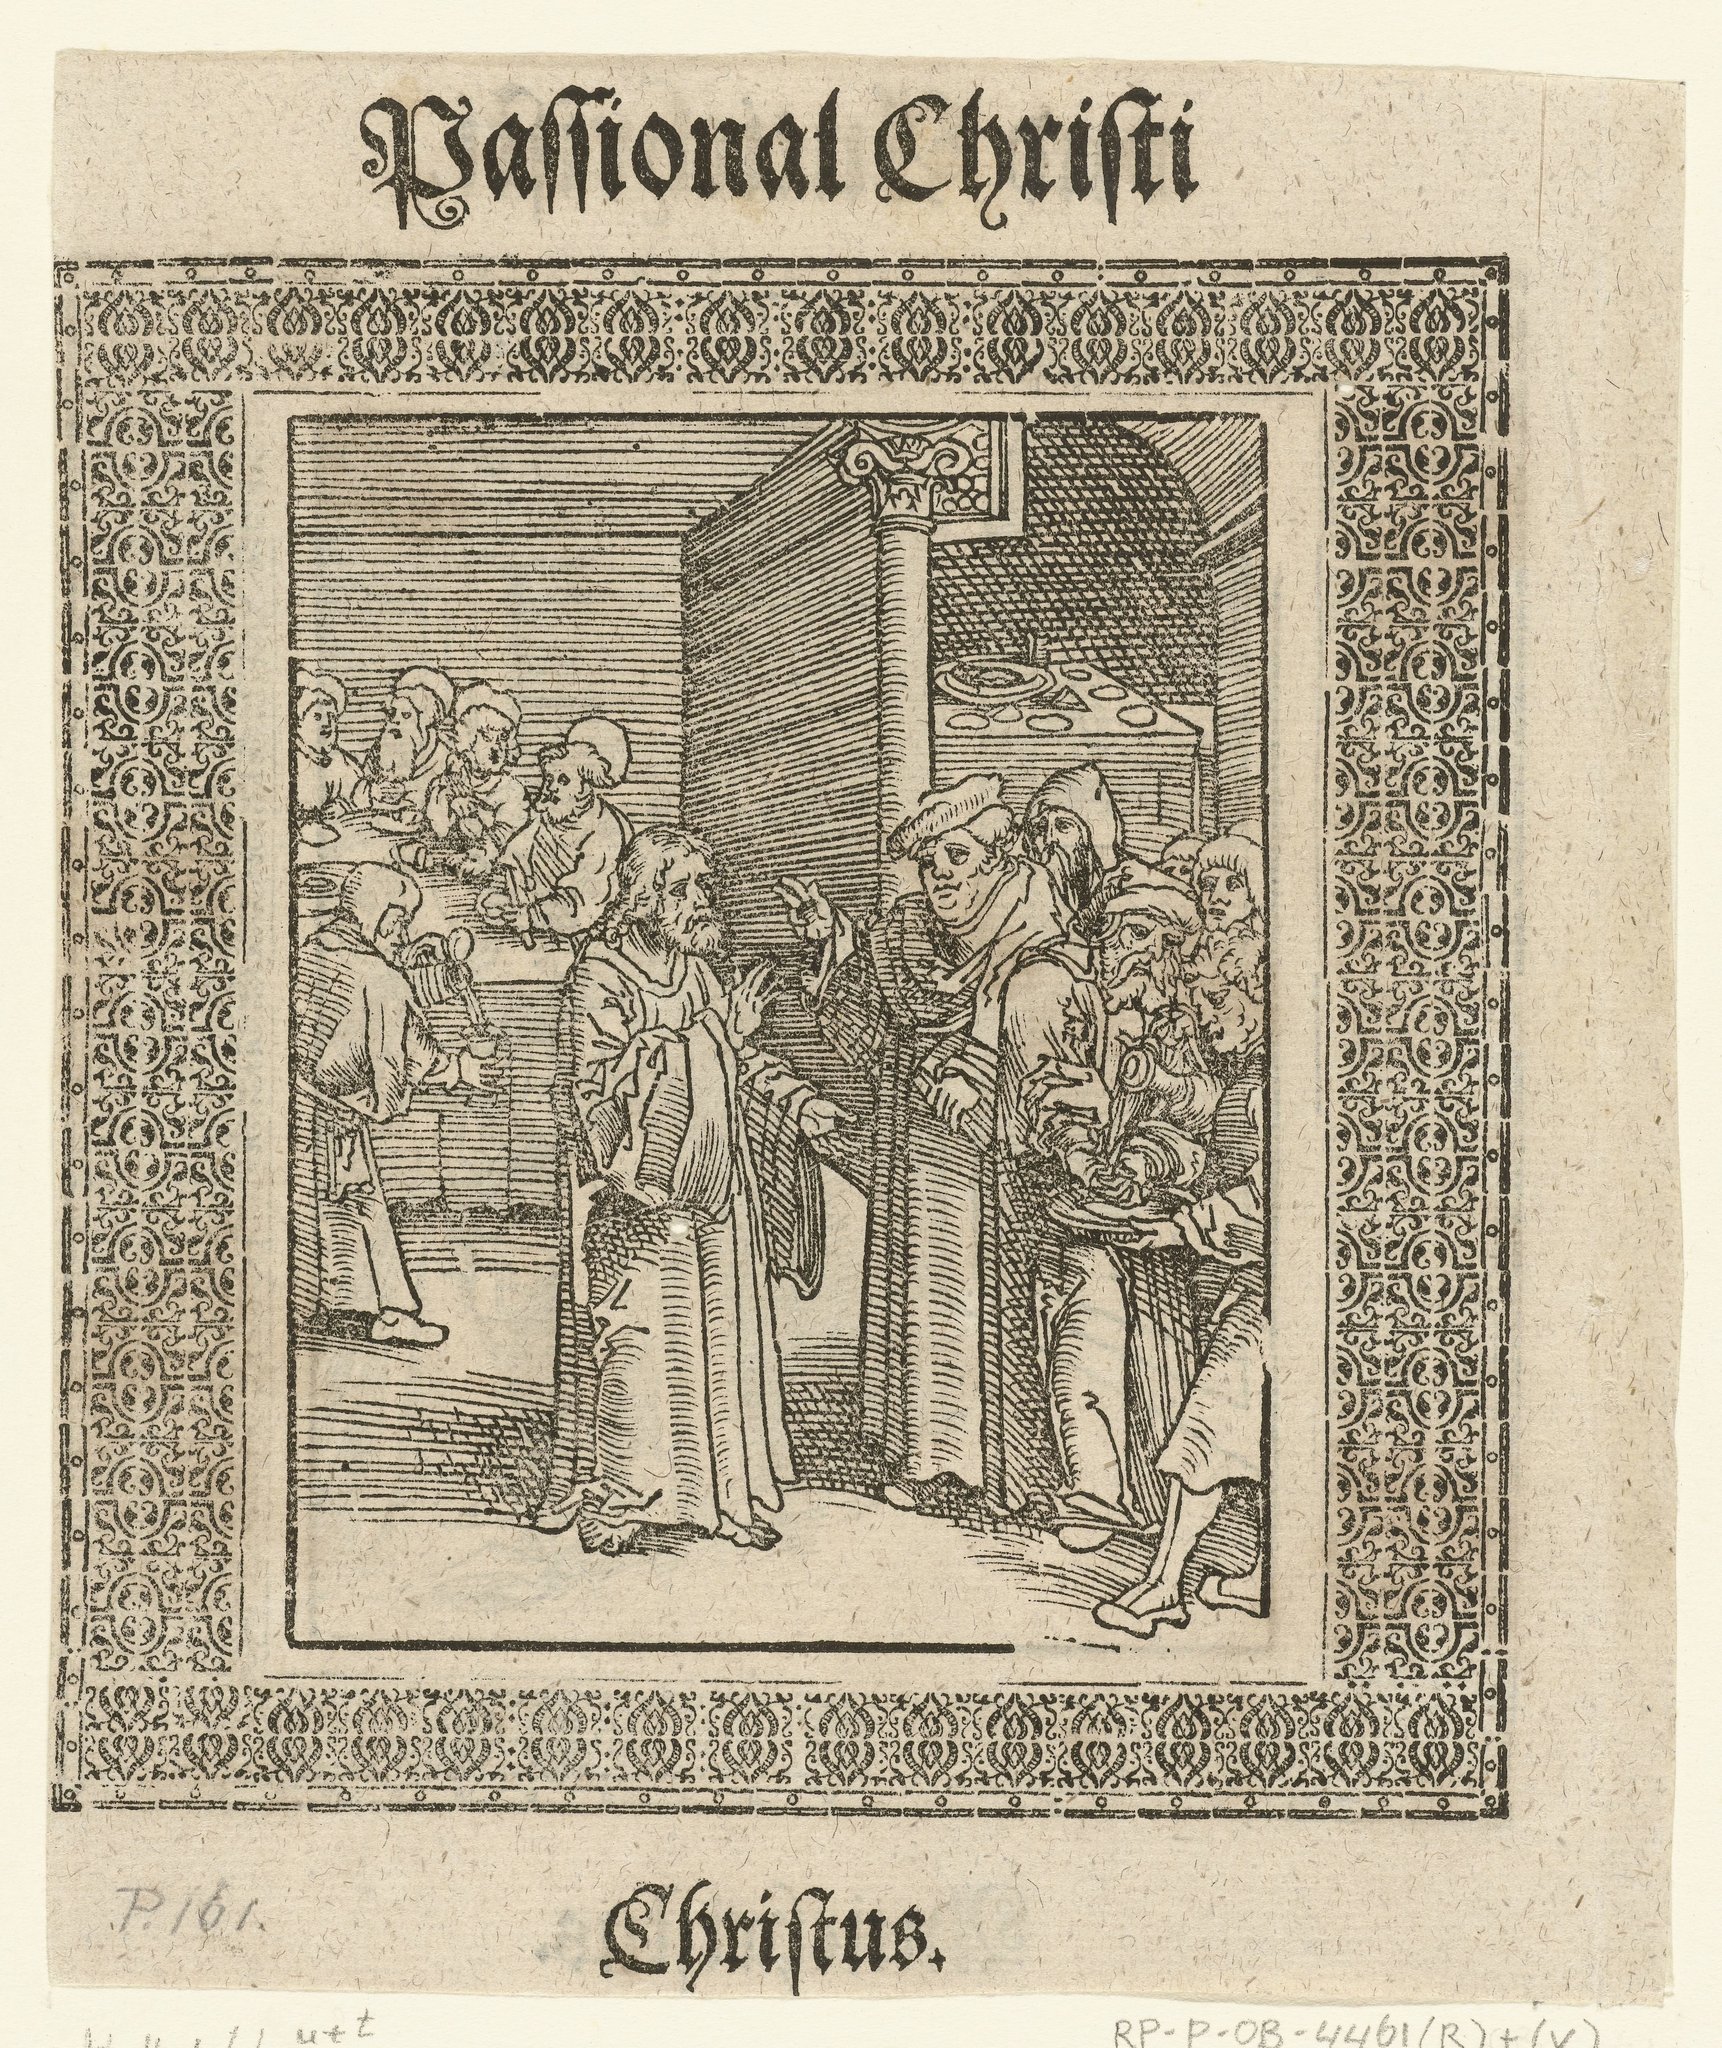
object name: print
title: Christus gebruikt maaltijd bij Farizeeër en weigert handen te wassen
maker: lucas cranach (i)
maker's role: draughtsman, print maker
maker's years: 1472-1553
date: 1521-1522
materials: paper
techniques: woodcut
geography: wittenberg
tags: meal at the house of a pharisee; christ and his disciples do not submit to the ritual washing (luke 11:37-41)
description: De tegenhanger van deze prent is de voorstelling Paus zegent monniken en nonnen, zie RP-P-OB-4462(V). Blad uit: Passional Christi und Antichristi, Wittenberg 1521-1522, Johann Grünenberg. In 1521-1522 verschenen veel verschillende uitgaven van dit populaire werk van Maarten Luther. In de collectie van het RMA bevindt zich de complete serie van zesentwintig afbeeldingen uit een van deze uitgaven. De pagina's zijn op een kleiner formaat gesneden, onder iedere voorstelling stond oorspronkelijk een aantal regels Duitse tekst. De bladen hebben allemaal op dezelfde plaats twee kleine gaatjes van vraat door ongedierte wat er op wijst dat ze behoren tot hetzelfde exemplaar.